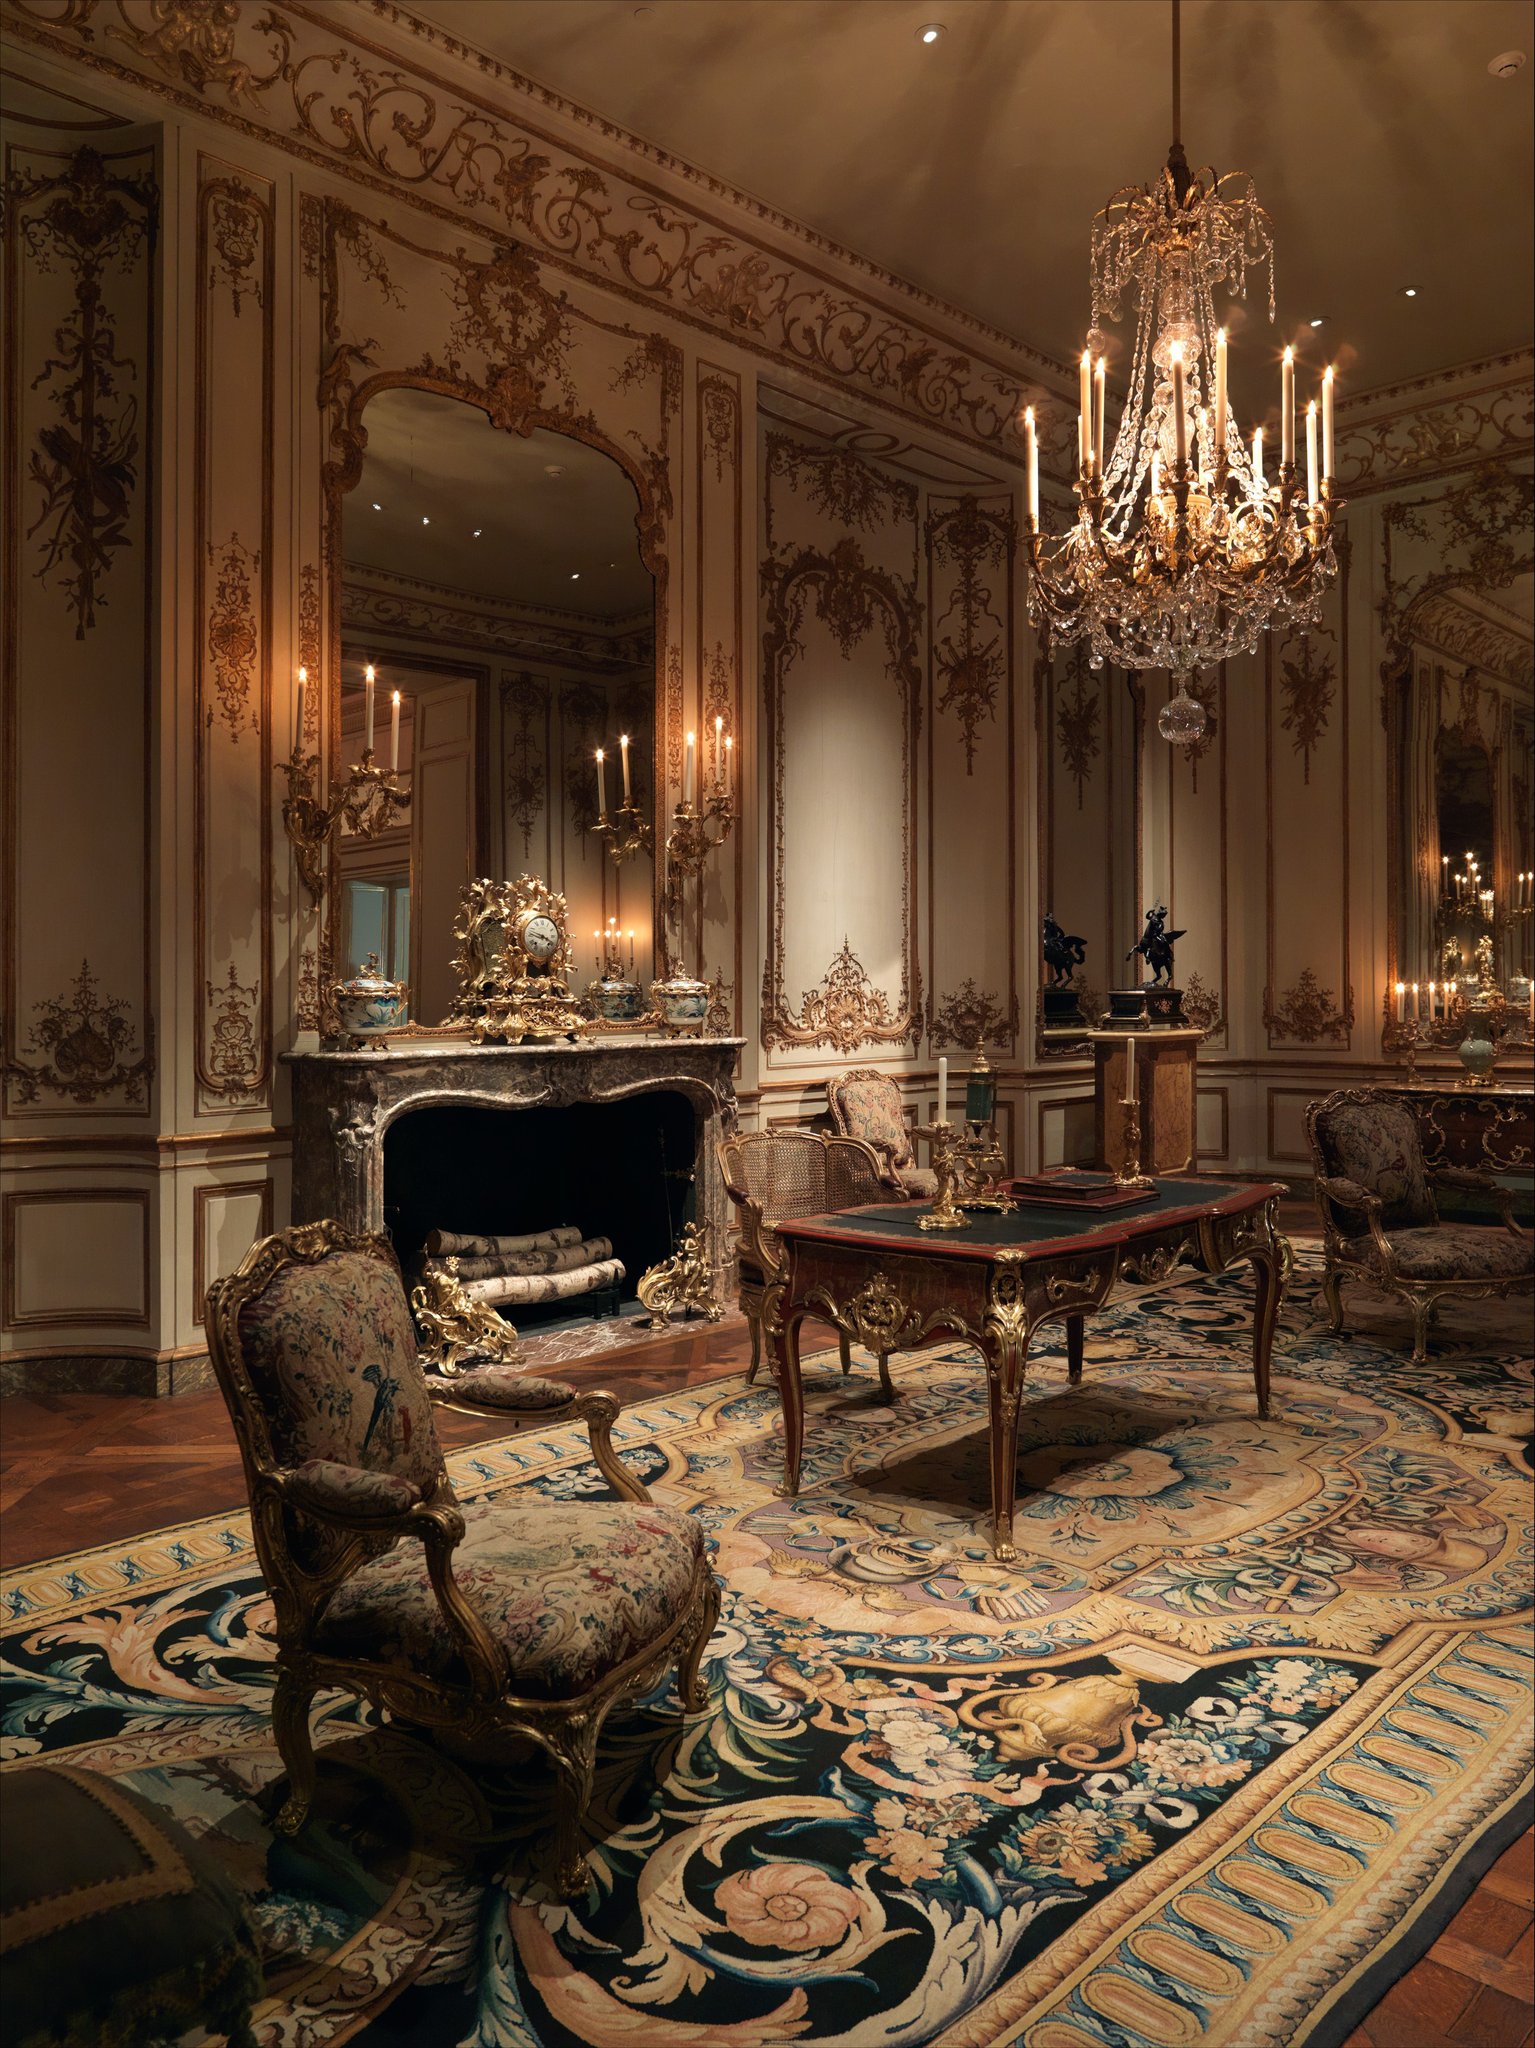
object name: period room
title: Boiserie from the Hôtel de Varengeville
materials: wood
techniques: carving, gilding, painting